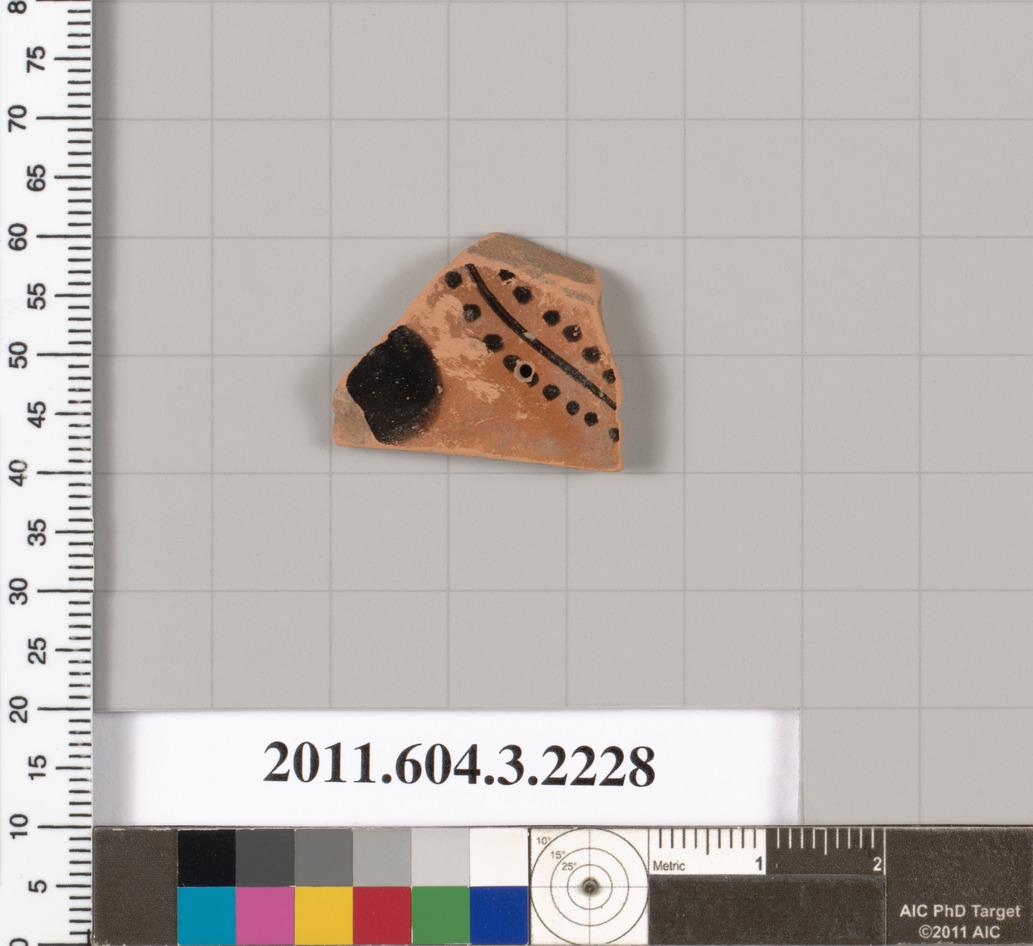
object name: kylix fragment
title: Terracotta fragment of a kylix (drinking cup)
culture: greek, attic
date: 534-501 BCE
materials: terracotta